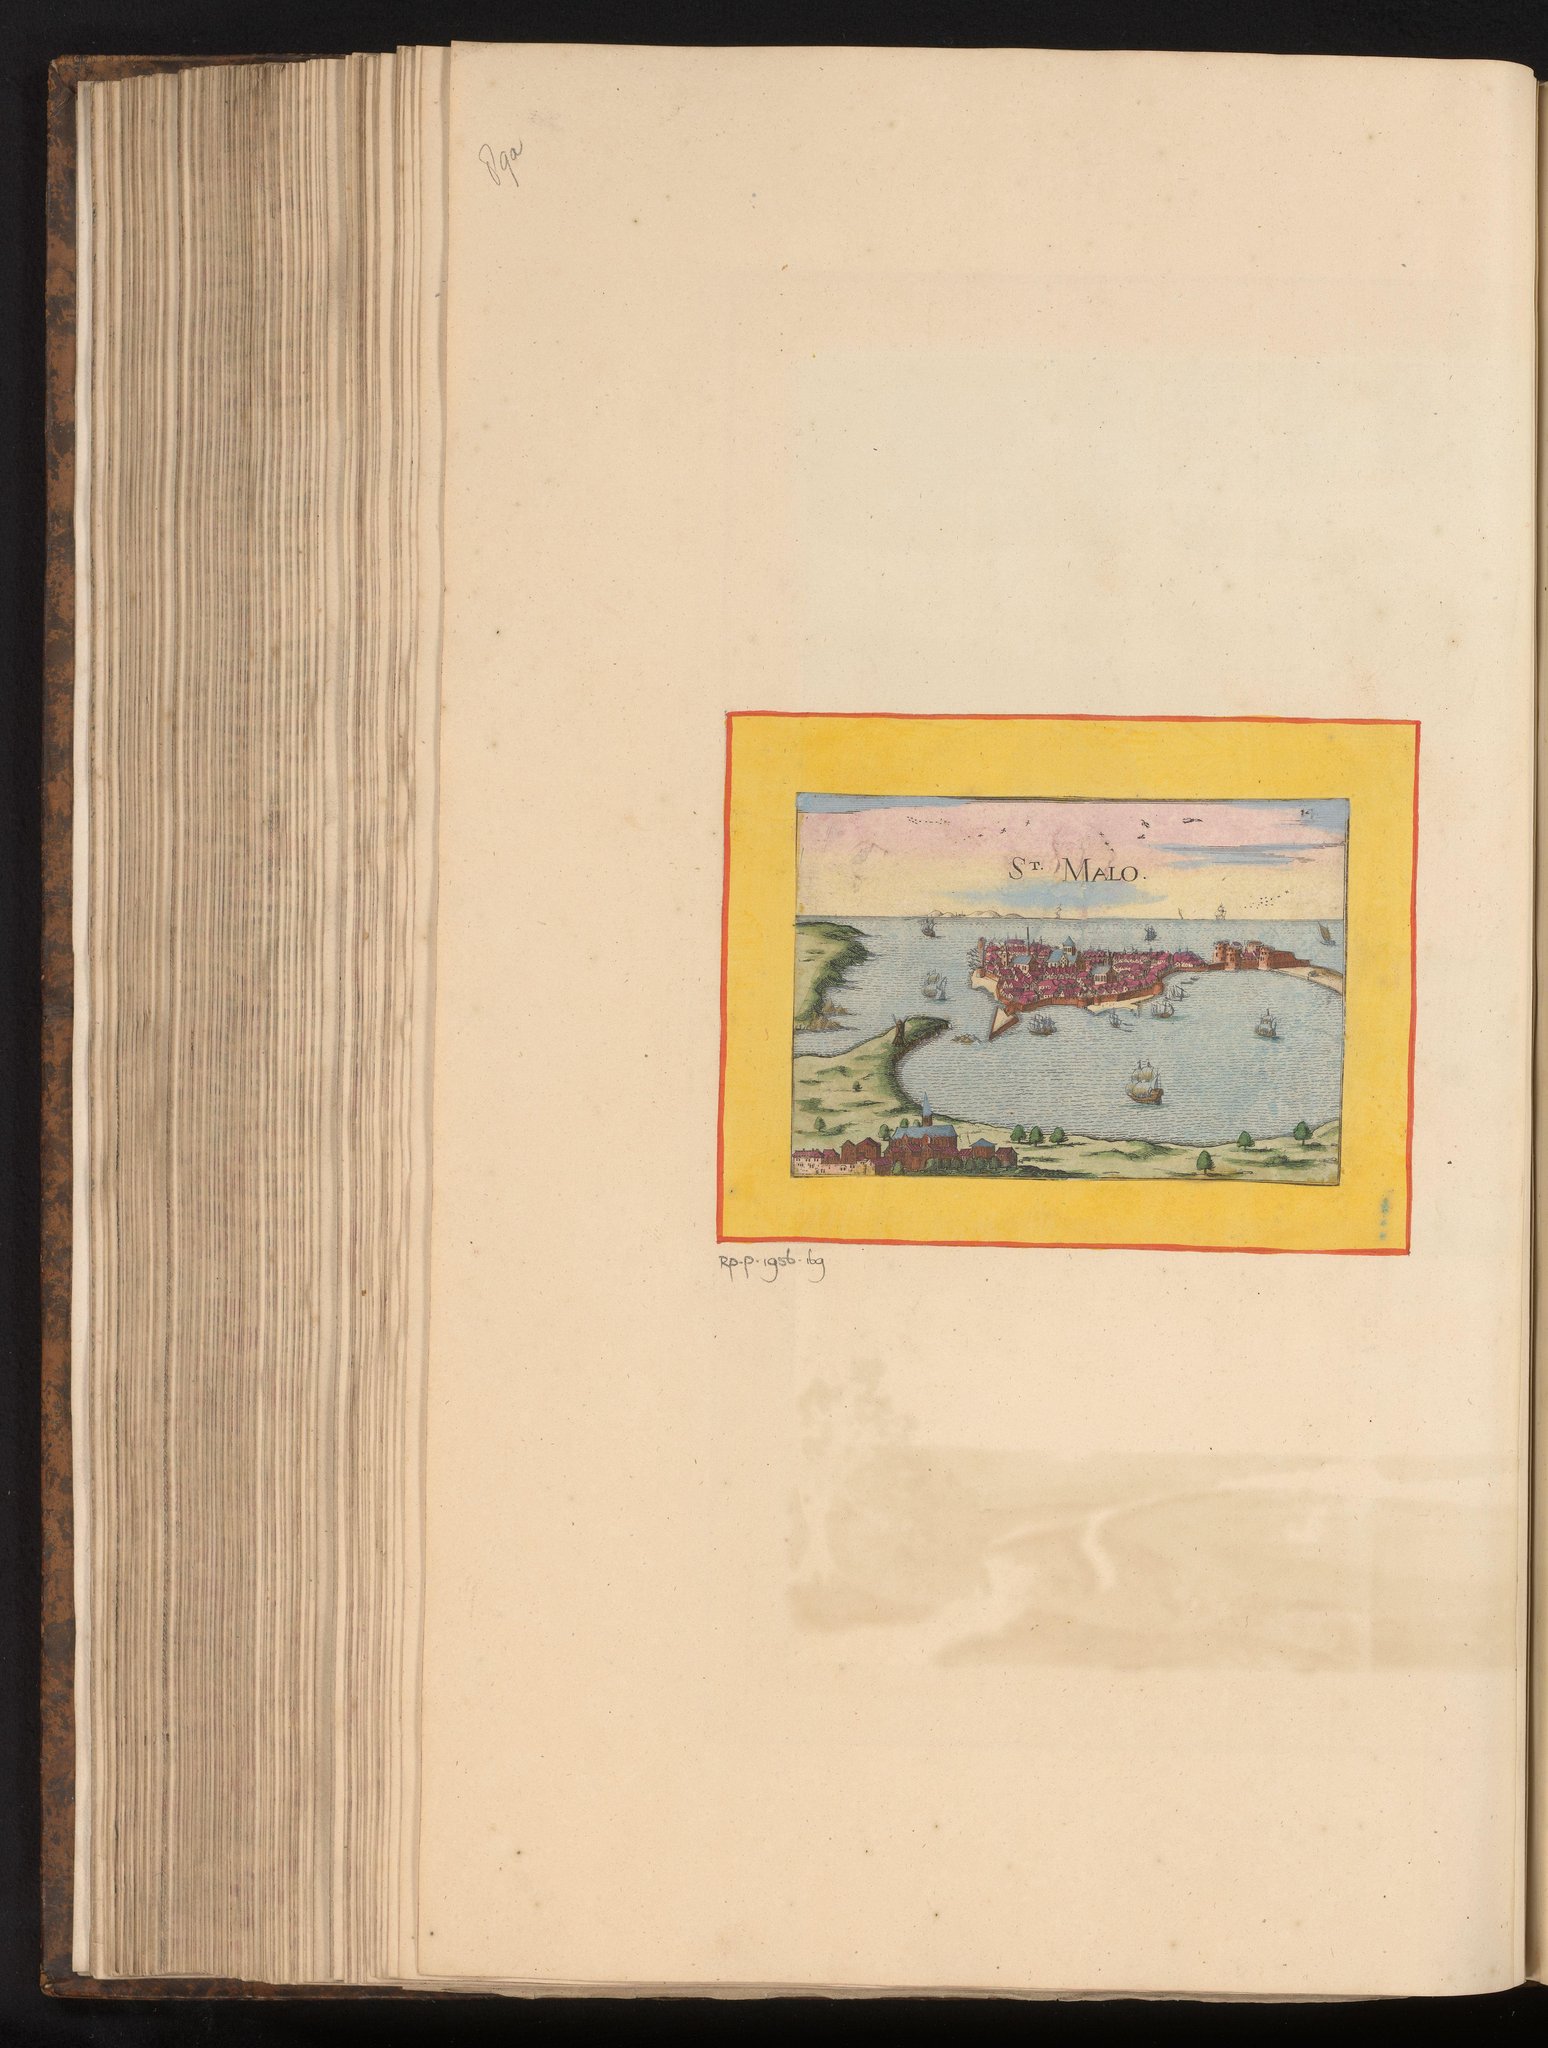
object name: print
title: Gezicht op Saint-Malo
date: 1638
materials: paper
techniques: engraving, etching, hand coloring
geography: paris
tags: city-view in general; 'veduta'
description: Prent uit: Tassin, Christophe. Les plans et profils de toutes les principales villes et lieux considérables de France (...). Parijs: Michel van Lochom, 1638, prent nummer 14 in het deel 'Bretaigne'.